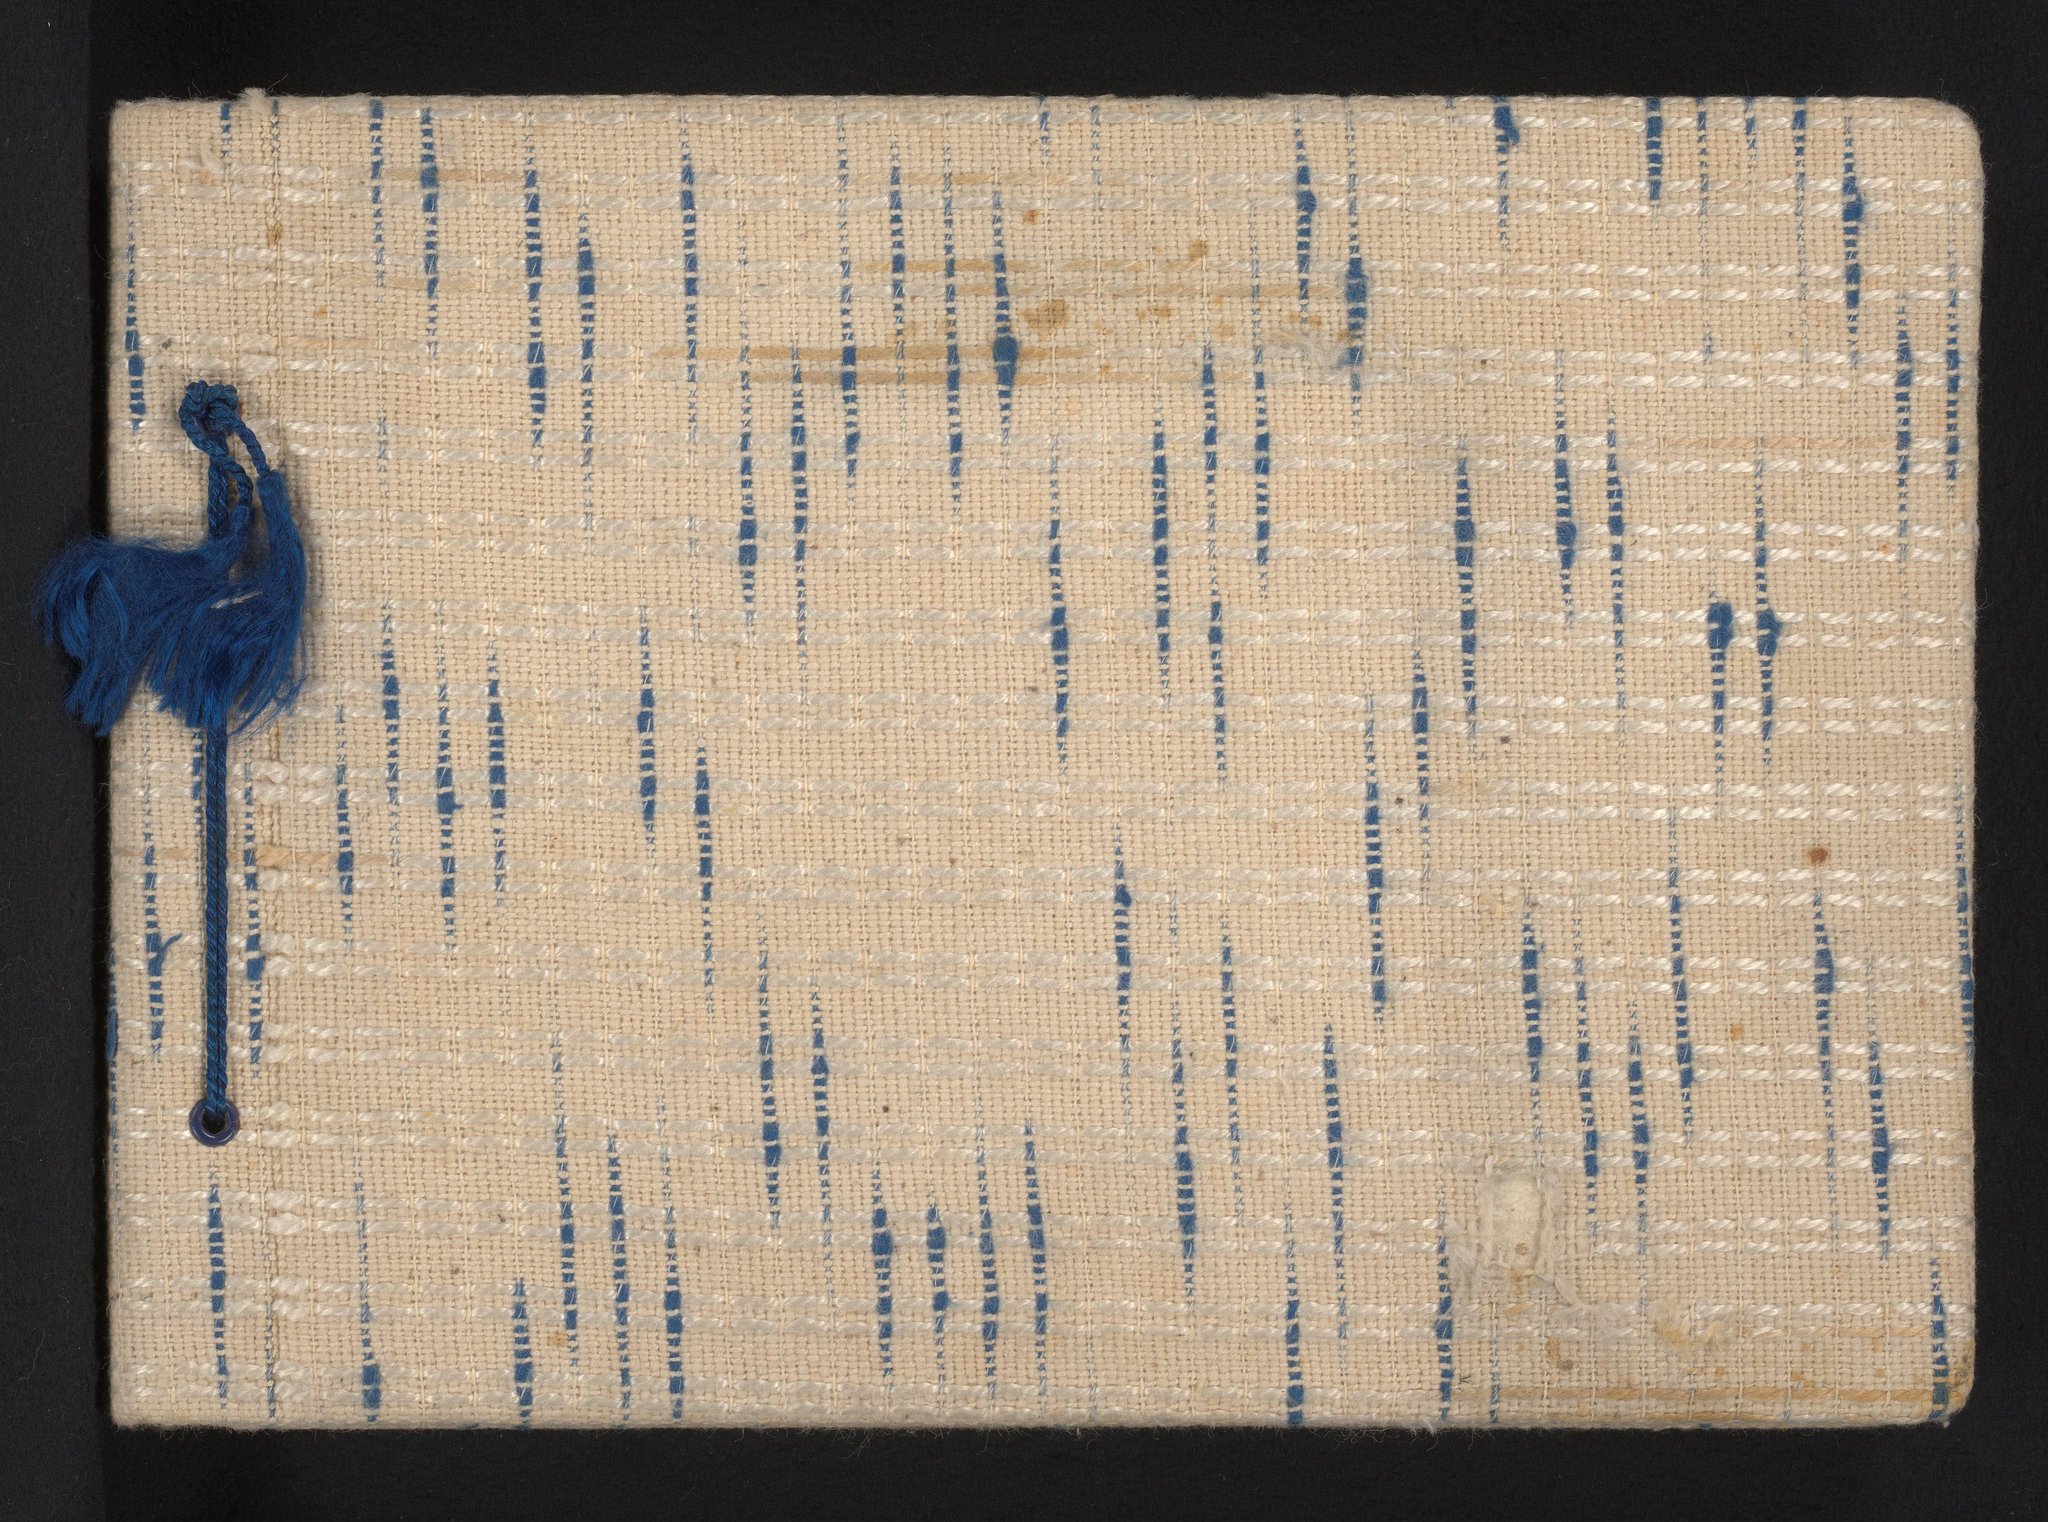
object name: slip in album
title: Fotoalbum Abrechnungsintendantur van de Wehrmacht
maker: Anonymous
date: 1941-1943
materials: cardboard, linen, paper, photographic support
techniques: gelatin silver print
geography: yugoslavia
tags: leiden, amsterdam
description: Fotoalbum van een militair werkzaam bij de Abrechnungsintendantur (soort salarisadministratie) van de Wehrmacht. Blauw-wit stoffen omslag. Het album bevat 24 zwarte bladen met in totaal 199 foto's. De samensteller werkte van 1 oktober 1941 tot 31 maart 1942 in Leiden en van 1 april 1942 tot 16 augustus 1942 in Apeldoorn. Album begint met foto's uit Amsterdam en Middelburg (schade aan stadhuis). Sommige foto's uit Apeldoorn zouden kunnen zijn gemaakt in of bij Het Loo. Tijdens WO II werd dit o.a. gebruikt als inkwartieringscentrum voor de Duitse troepen. Veel foto's waarop twee vrouwen voorkomen, waarschijnlijk de echtgenote en dochter van de samensteller. Ook uitstapjes naar Volendam en Marken, Amsterdam en het Rijksmuseum. In 1943 wordt de samensteller overgeplaatst naar Kroatië, met foto's van Zagreb en Mostar.